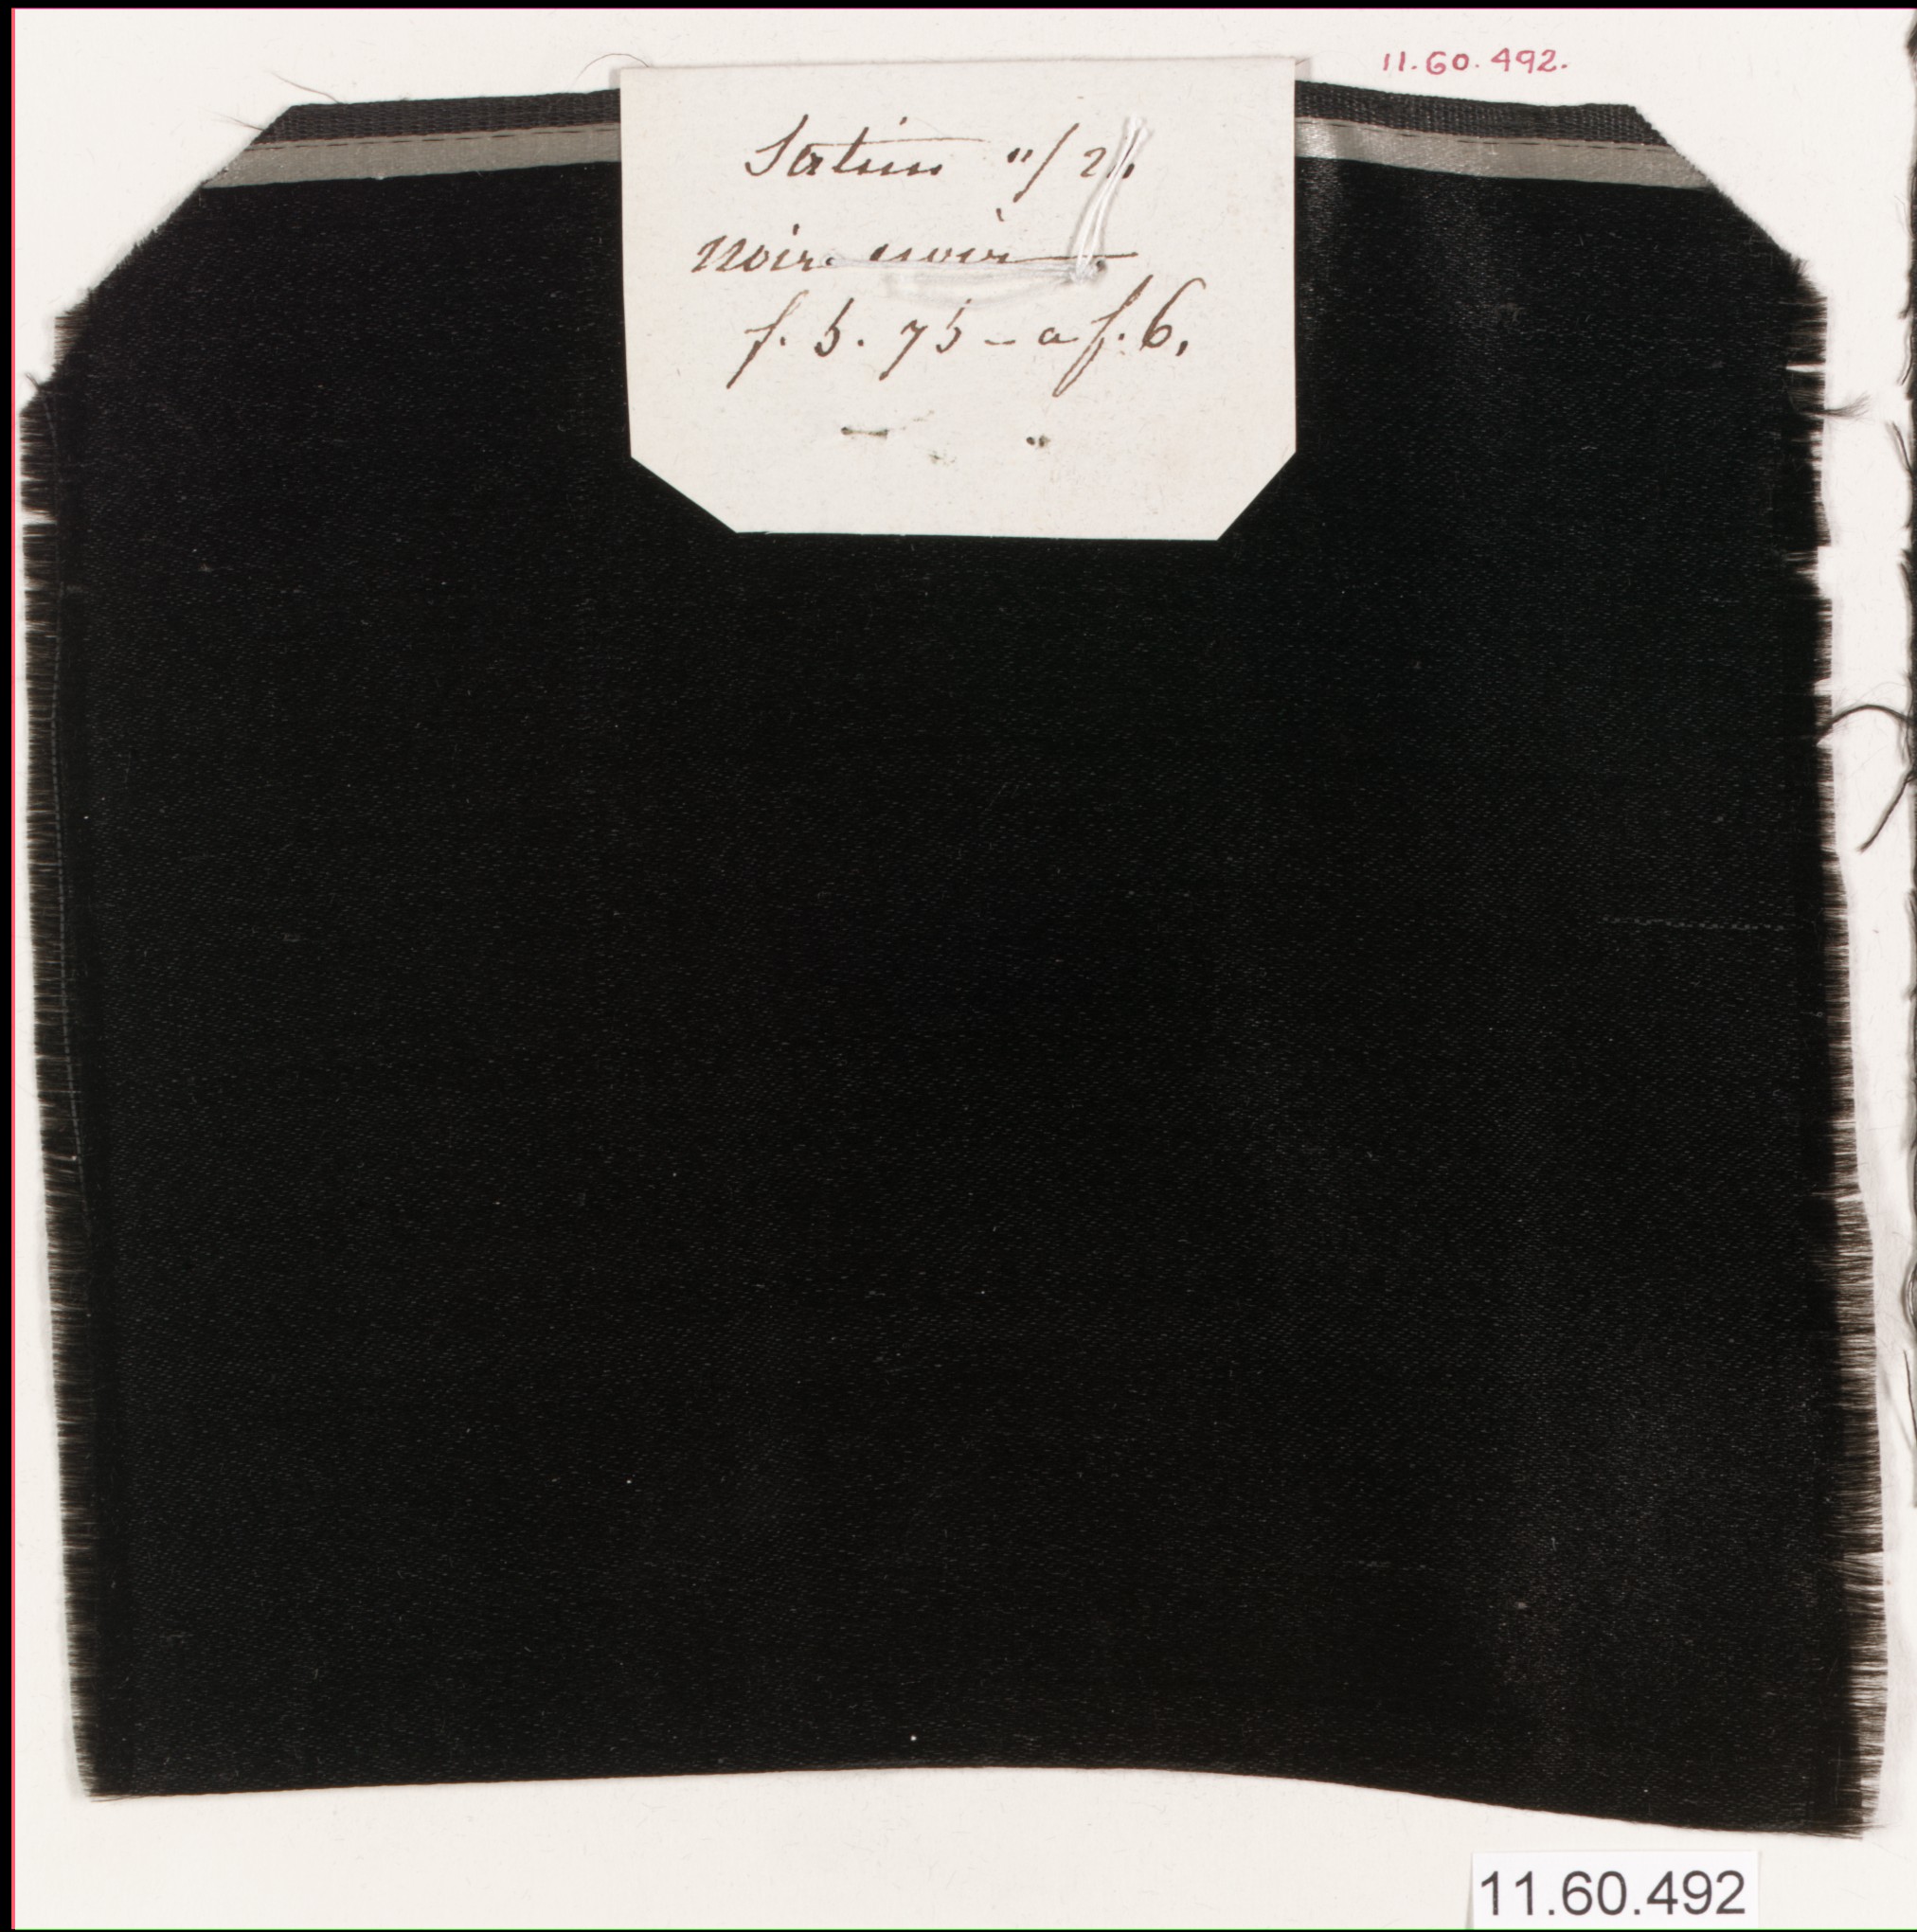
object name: sample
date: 1801-1850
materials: silk